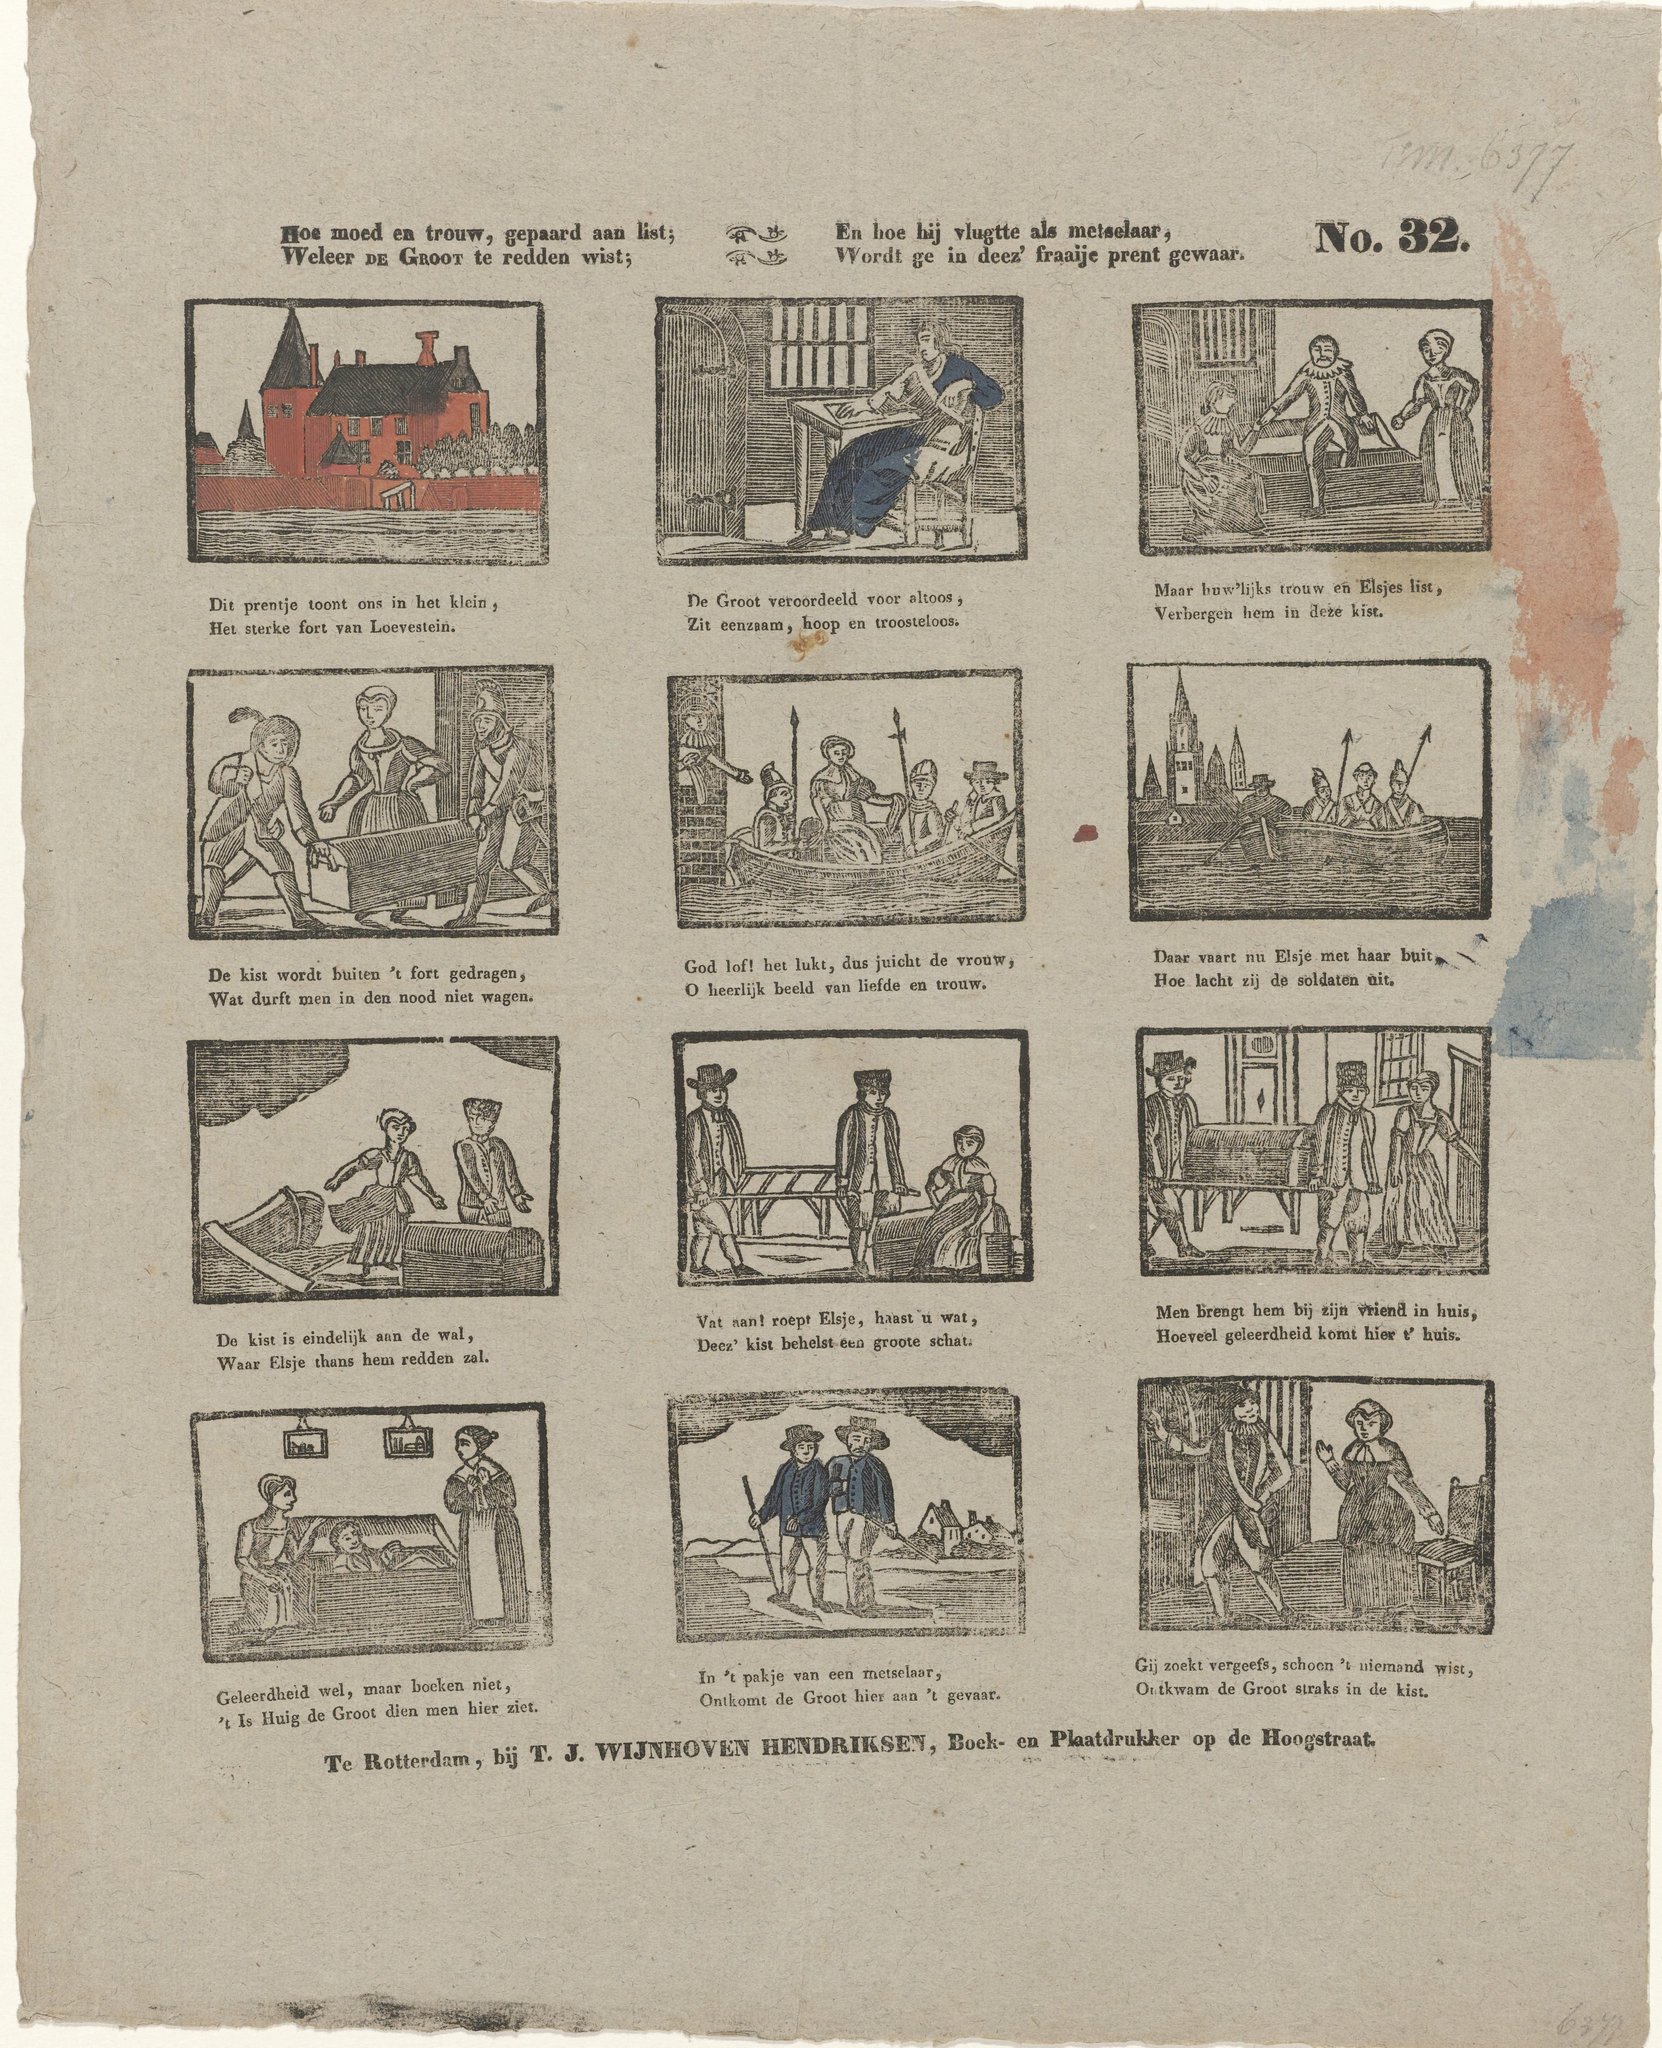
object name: print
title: Hoe moed en trouw, gepaard aan list; / Weleer De Groot te redden wist; / En hoe hij vlugtte als metselaar, / Wordt ge in deez' fraaije prent gewaar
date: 1832-1850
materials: paper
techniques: colour, letterpress printing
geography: netherlands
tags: delft, hugo de groot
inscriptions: collector's mark: Lugt 2228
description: Blad met twaalf voorstellingen van de ontsnapping van Hugo de Groot uit Slot Loevestein in 1621. Onder elk plaatje een tweeregelig versje. Genummerd rechtsboven: No. 32. Ca. 1832-1849.